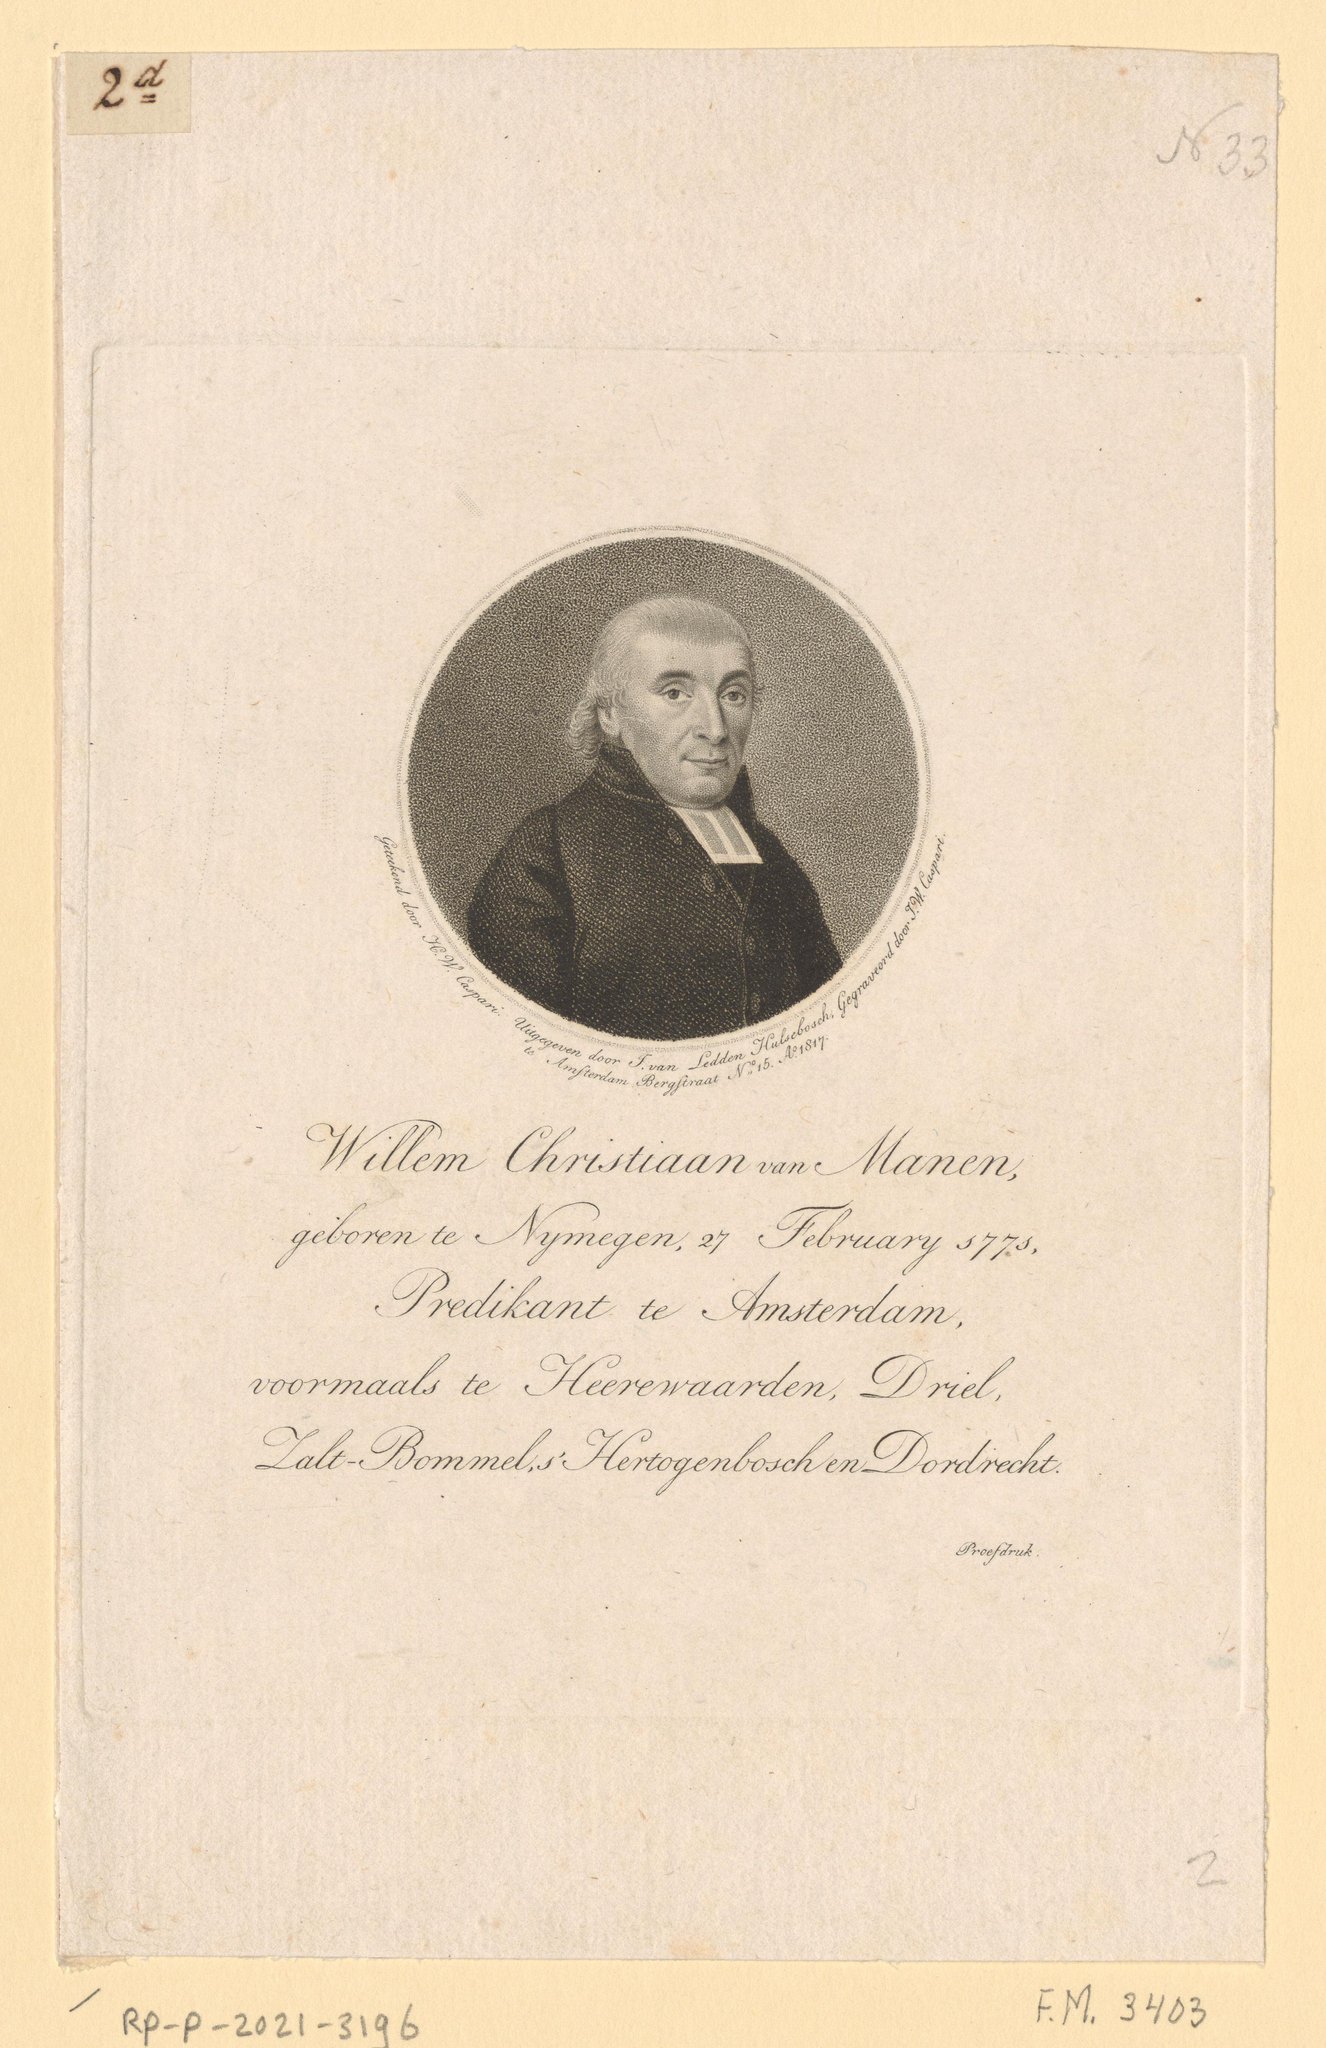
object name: print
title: Portret van Willem Christiaan van Manen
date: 1817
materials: paper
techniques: stippling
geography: amsterdam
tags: historical persons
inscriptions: number: ‘2d’, number: ‘N33’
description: Met onderschrift in het Nederlands. Rechtsonder: proefdruk.